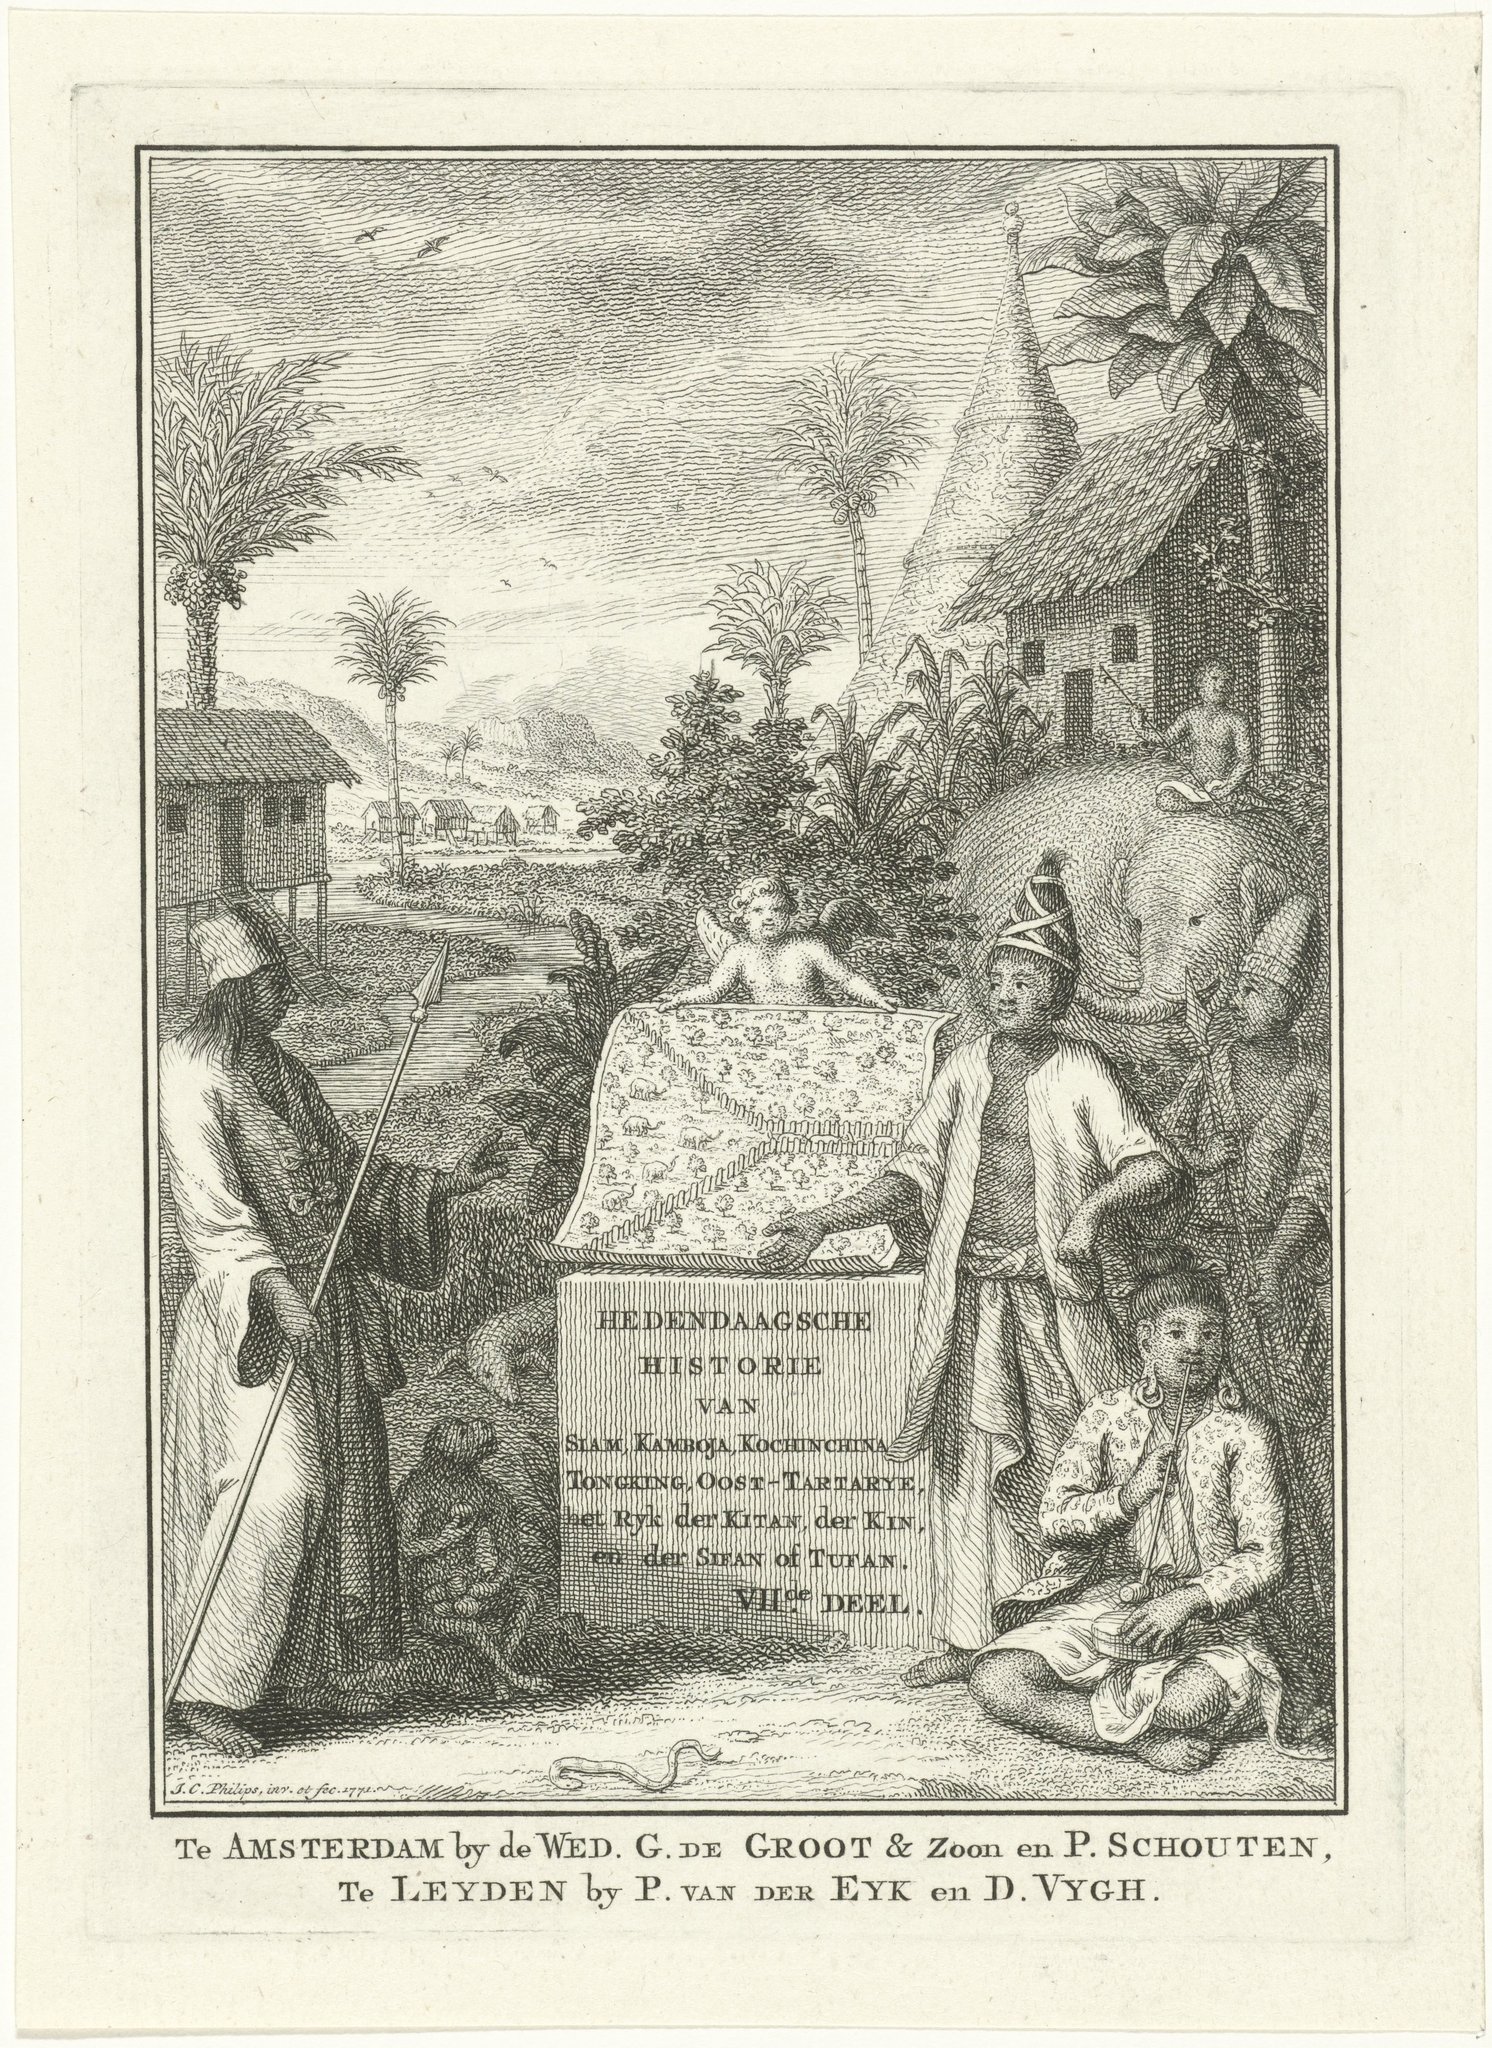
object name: print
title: Titelpagina voor: Thomas Salmon, Hedendaagsche historie, dl. 7, 1772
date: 1771-1772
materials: paper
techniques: engraving, etching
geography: amsterdam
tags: personifications of countries, nations, states, districts, etc., maps, atlases, landscapes in the non-temperate zone, exotic landscapes, human races; peoples; nationalities, trunked animals: elephant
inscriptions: collector's mark: Lugt 2228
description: Titelpagina voor: Salmon, Thomas. Hedendaagsche historie of het vervolg van de algemene historie (...) VIIde deel (...) Behelzende eene beschrijving van de landen, Gelegen in het Verdere Halfeiland van Indie; benevens (...). Amsterdam / Leiden: Weduwe G. de Groot en Petrus Schouten / P. van der Eyk en Daniel Vijgh, 1772.